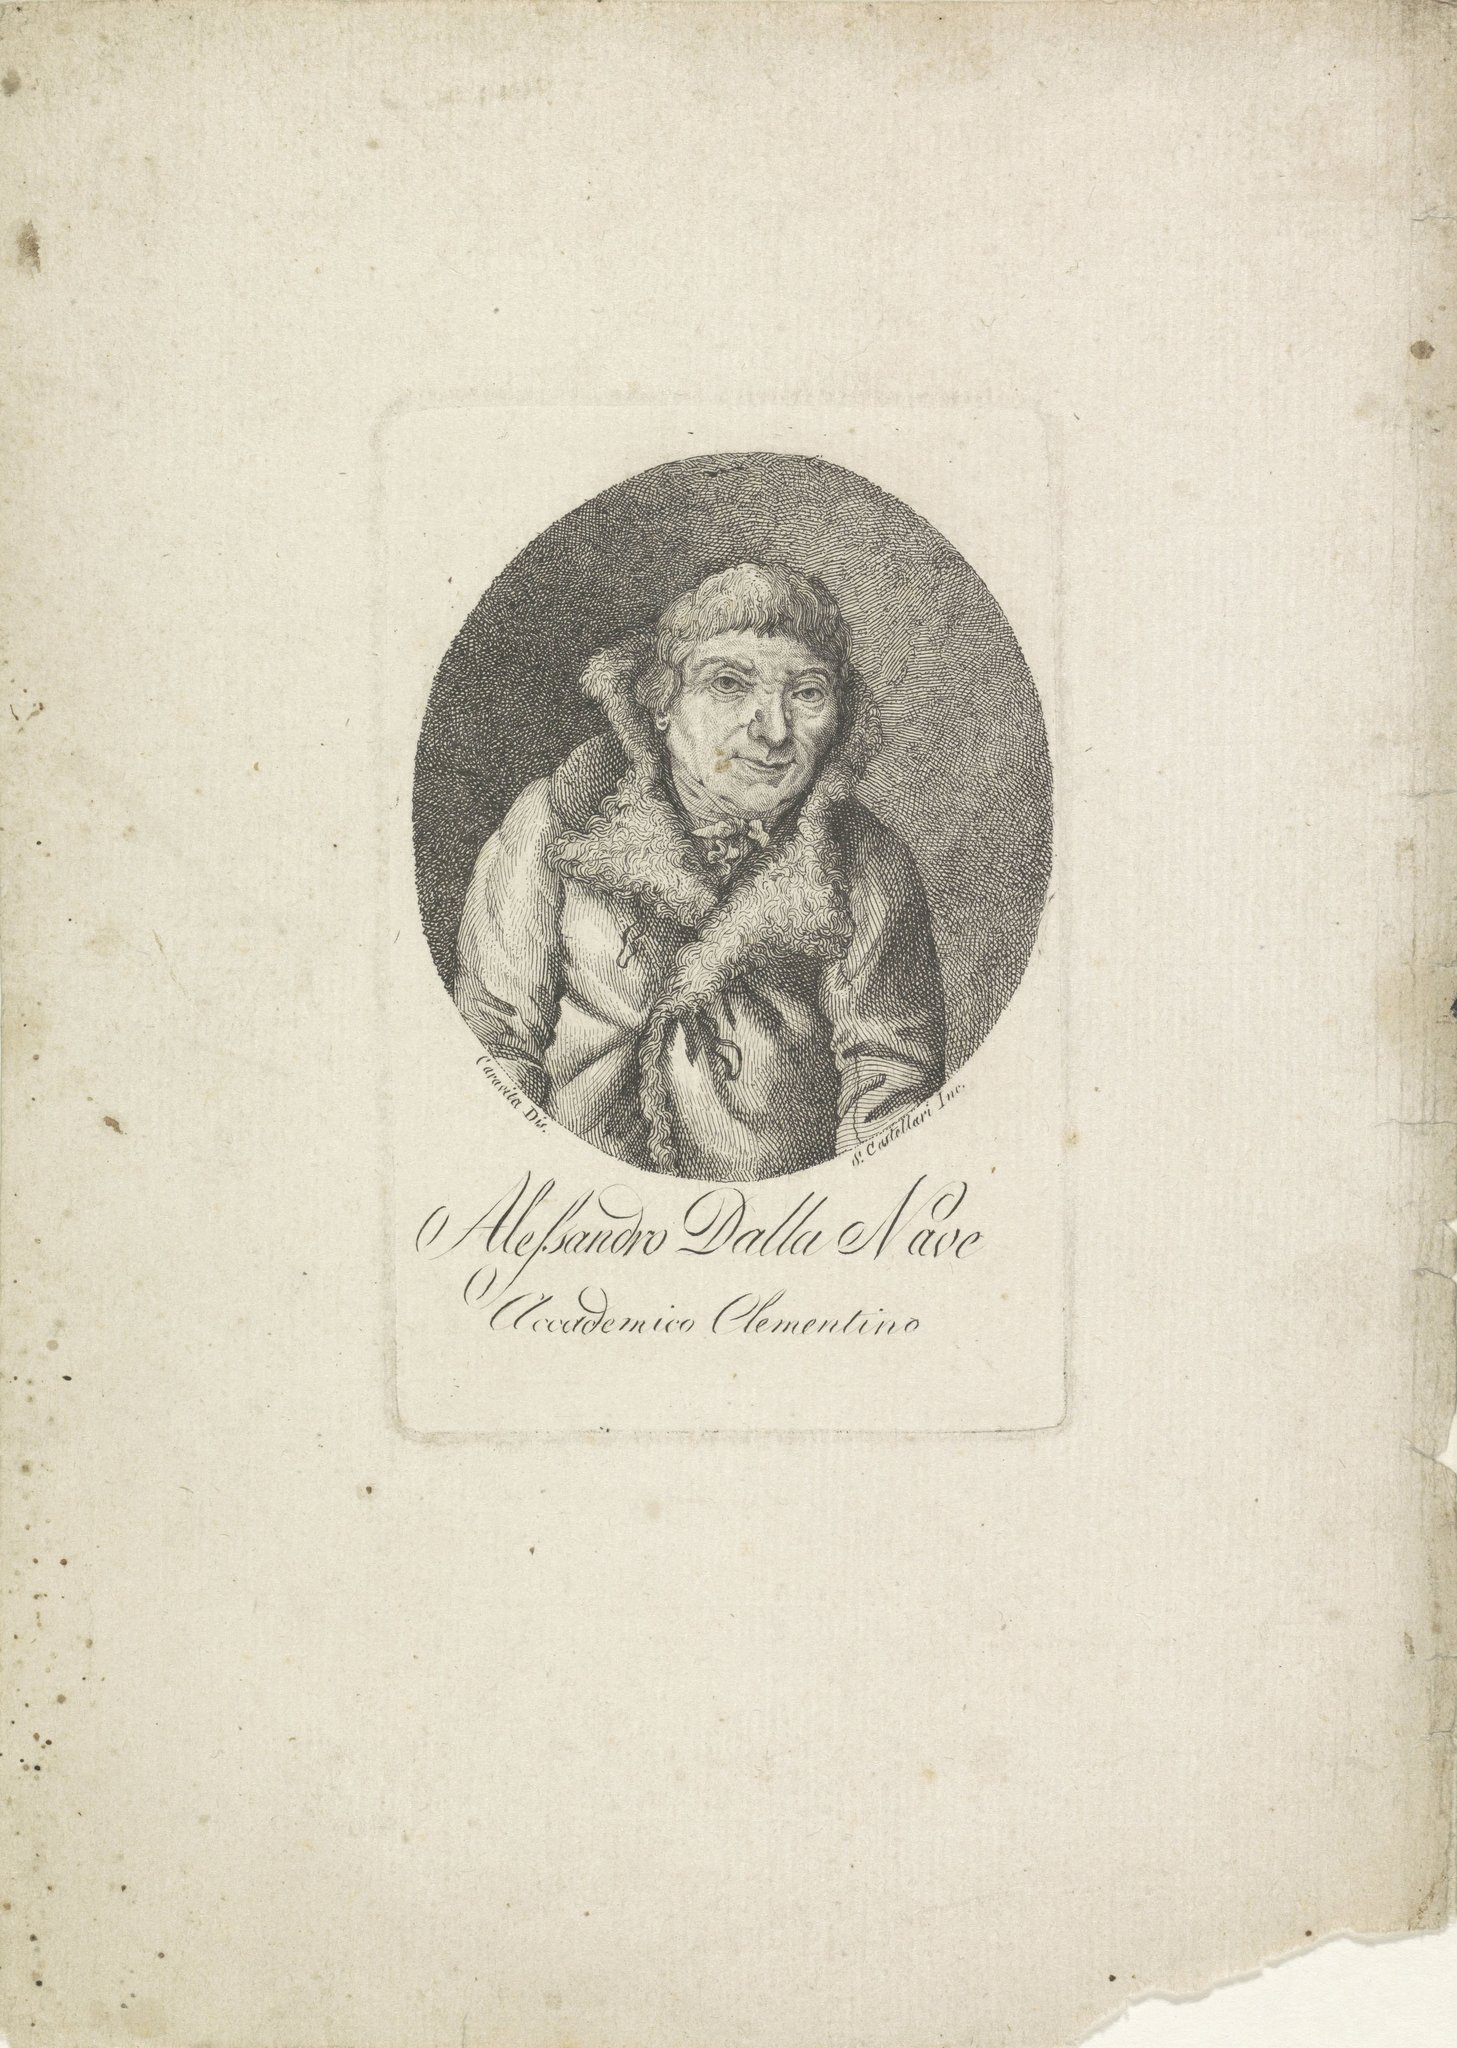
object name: print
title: Portret van schilder Alessandro dalla Nave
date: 1750-1850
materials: paper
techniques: etching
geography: italy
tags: painter, historical persons, portrait, self-portrait of artist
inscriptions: collector's mark: Lugt 2228